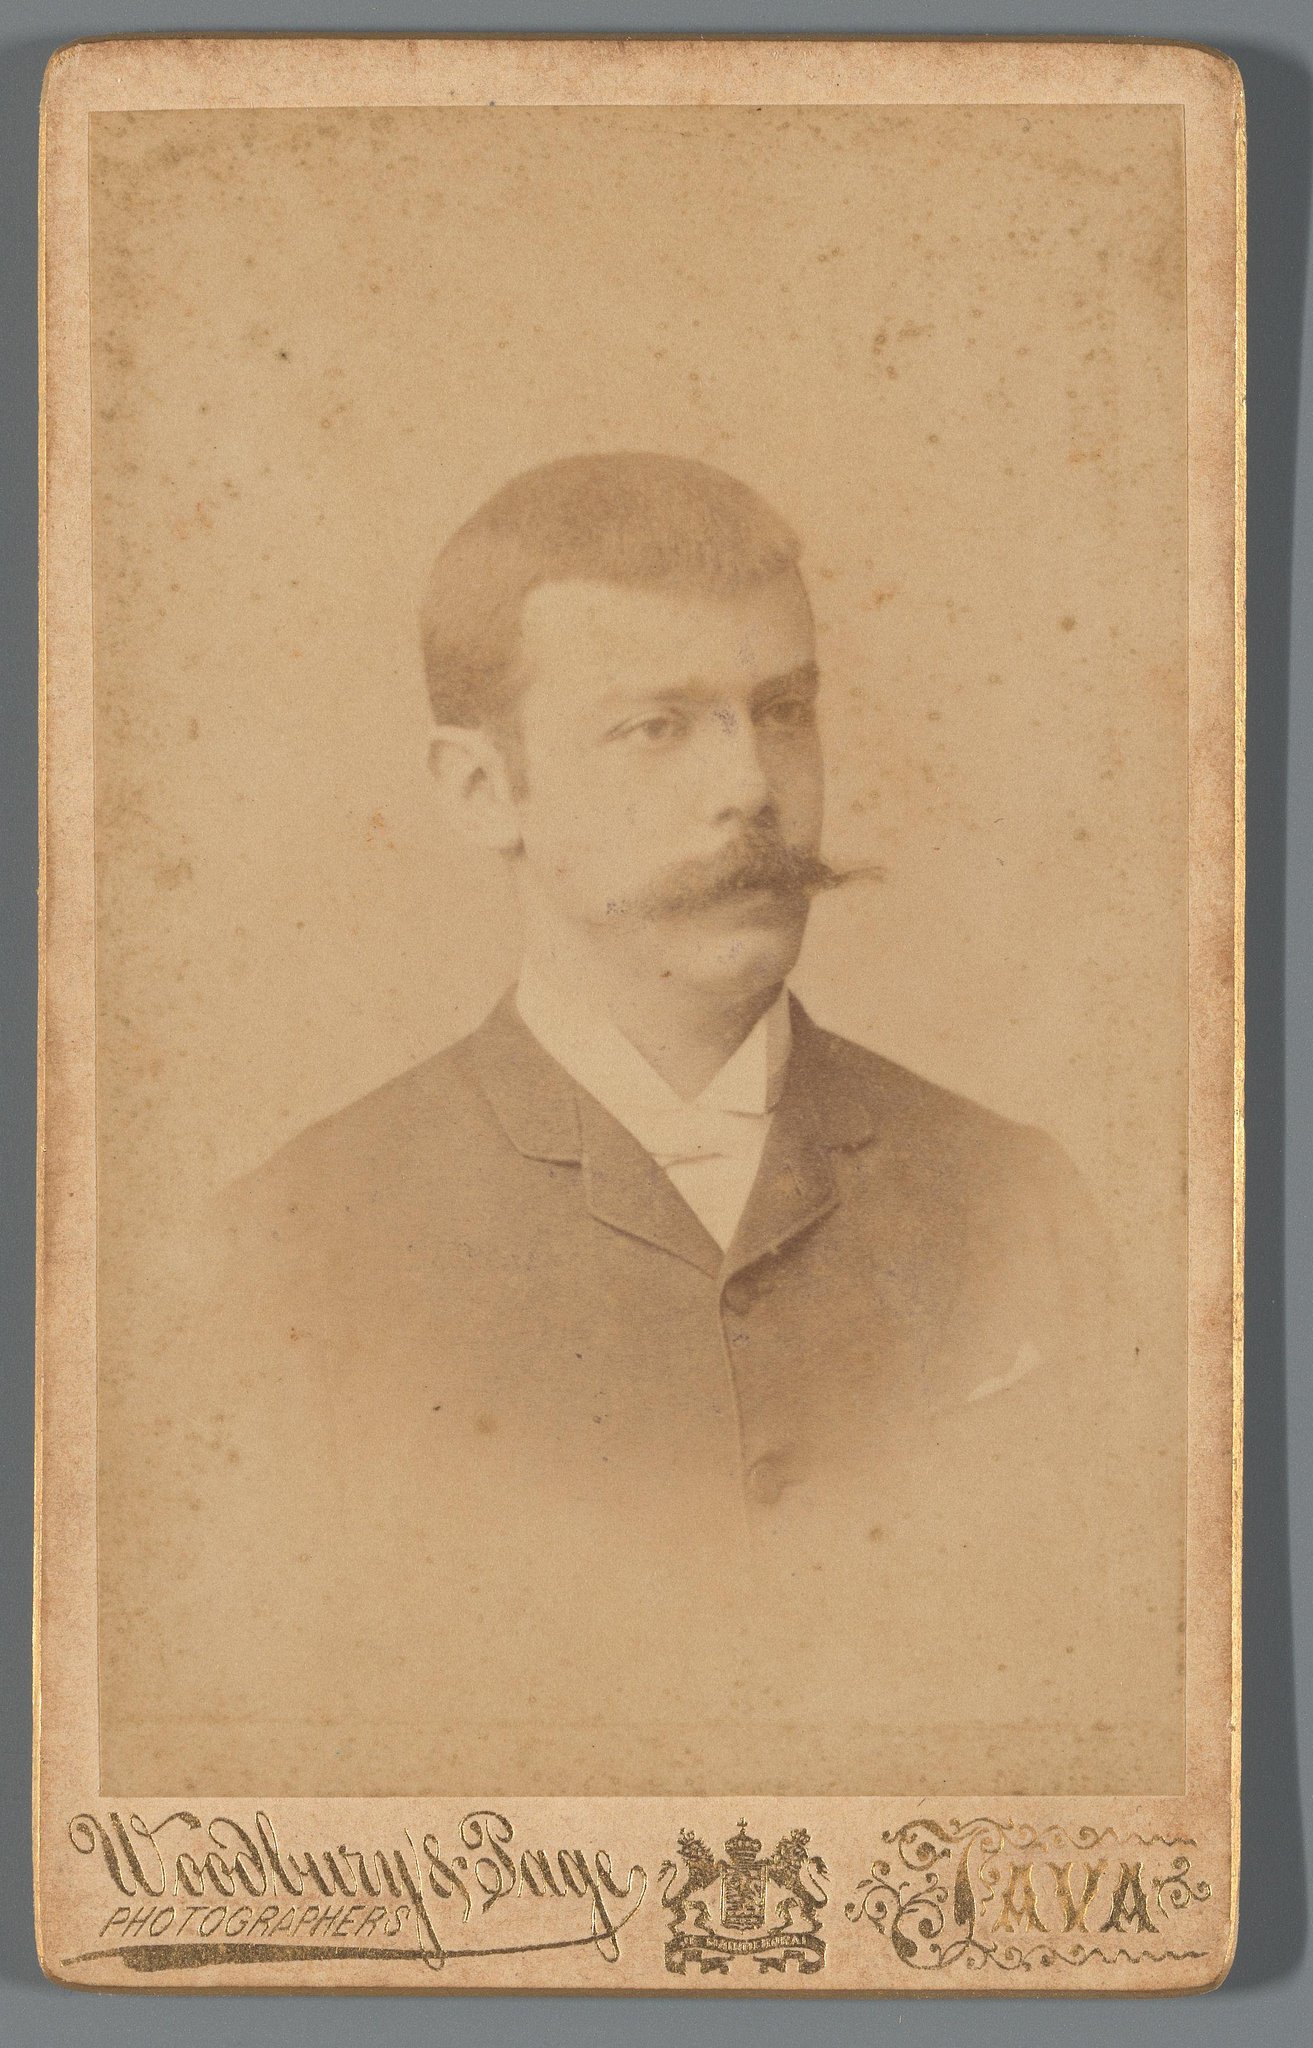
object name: photograph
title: Mr A van Blommestein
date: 1855-1910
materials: photographic support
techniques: photography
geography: java